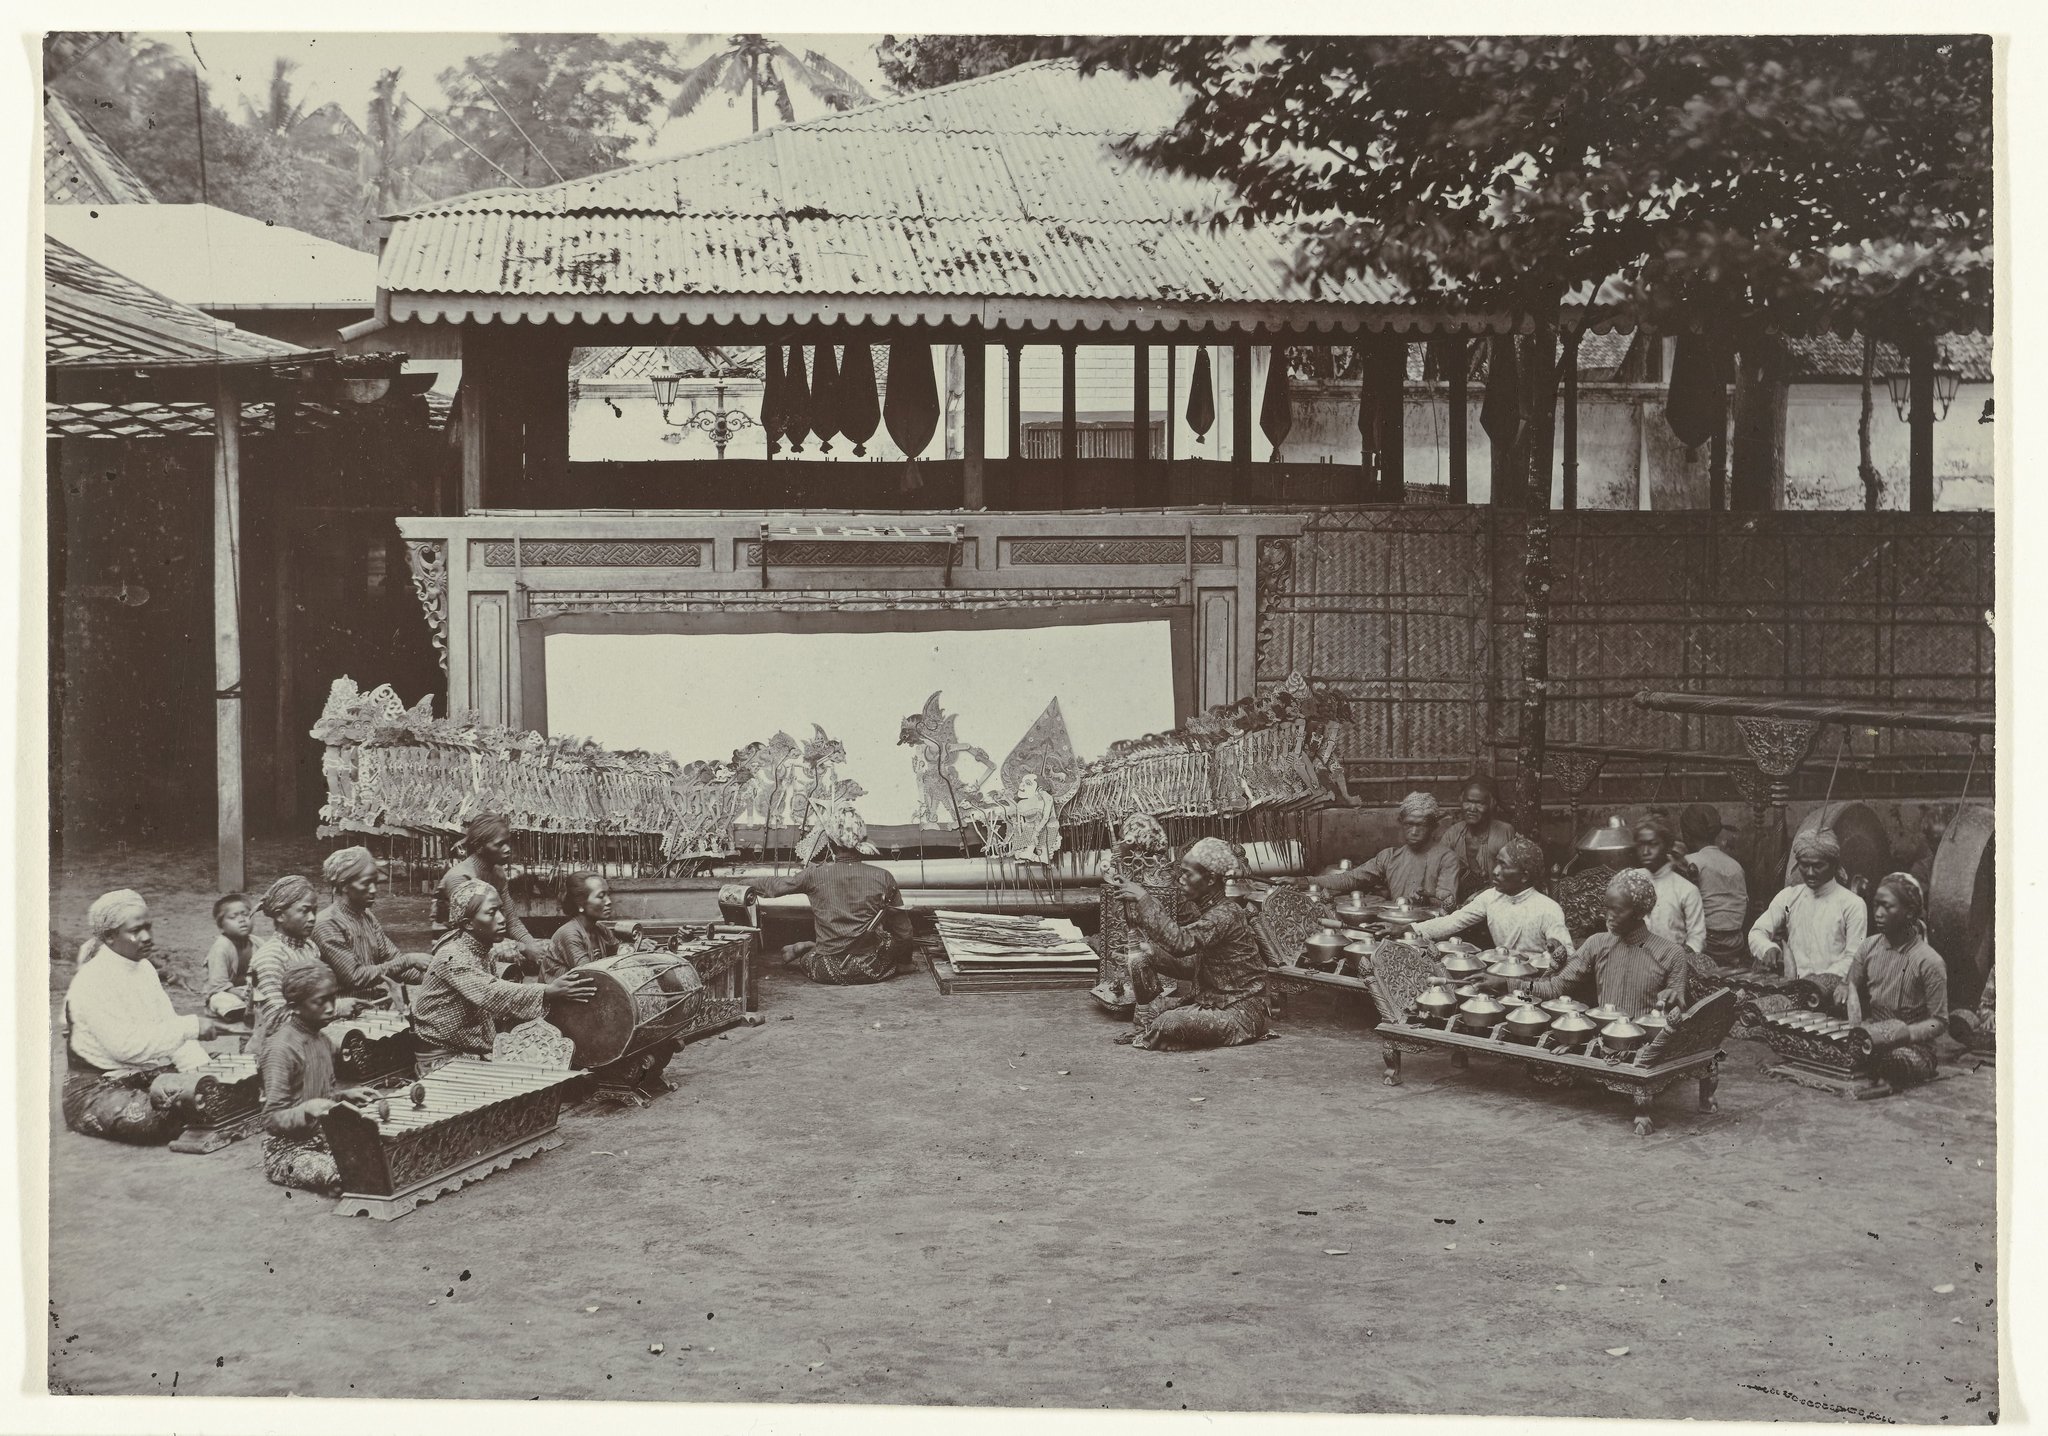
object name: photograph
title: A Gamelan Orchestra for a Shadow Puppet Performance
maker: kassian céphas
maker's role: fotograaf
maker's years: 1845-1912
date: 1890-1900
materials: cardboard, paper, photographic support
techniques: albumen print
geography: jogjakarta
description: Céphas was commissioned to photograph important rituals and performances at the royal palace (kraton) of Yogyakarta. Here a gamelan orchestra accompanies a wayang kulit play, in which the shadows of skilfully carved leather dolls are projected onto a screen. Such shows usually took place at night.